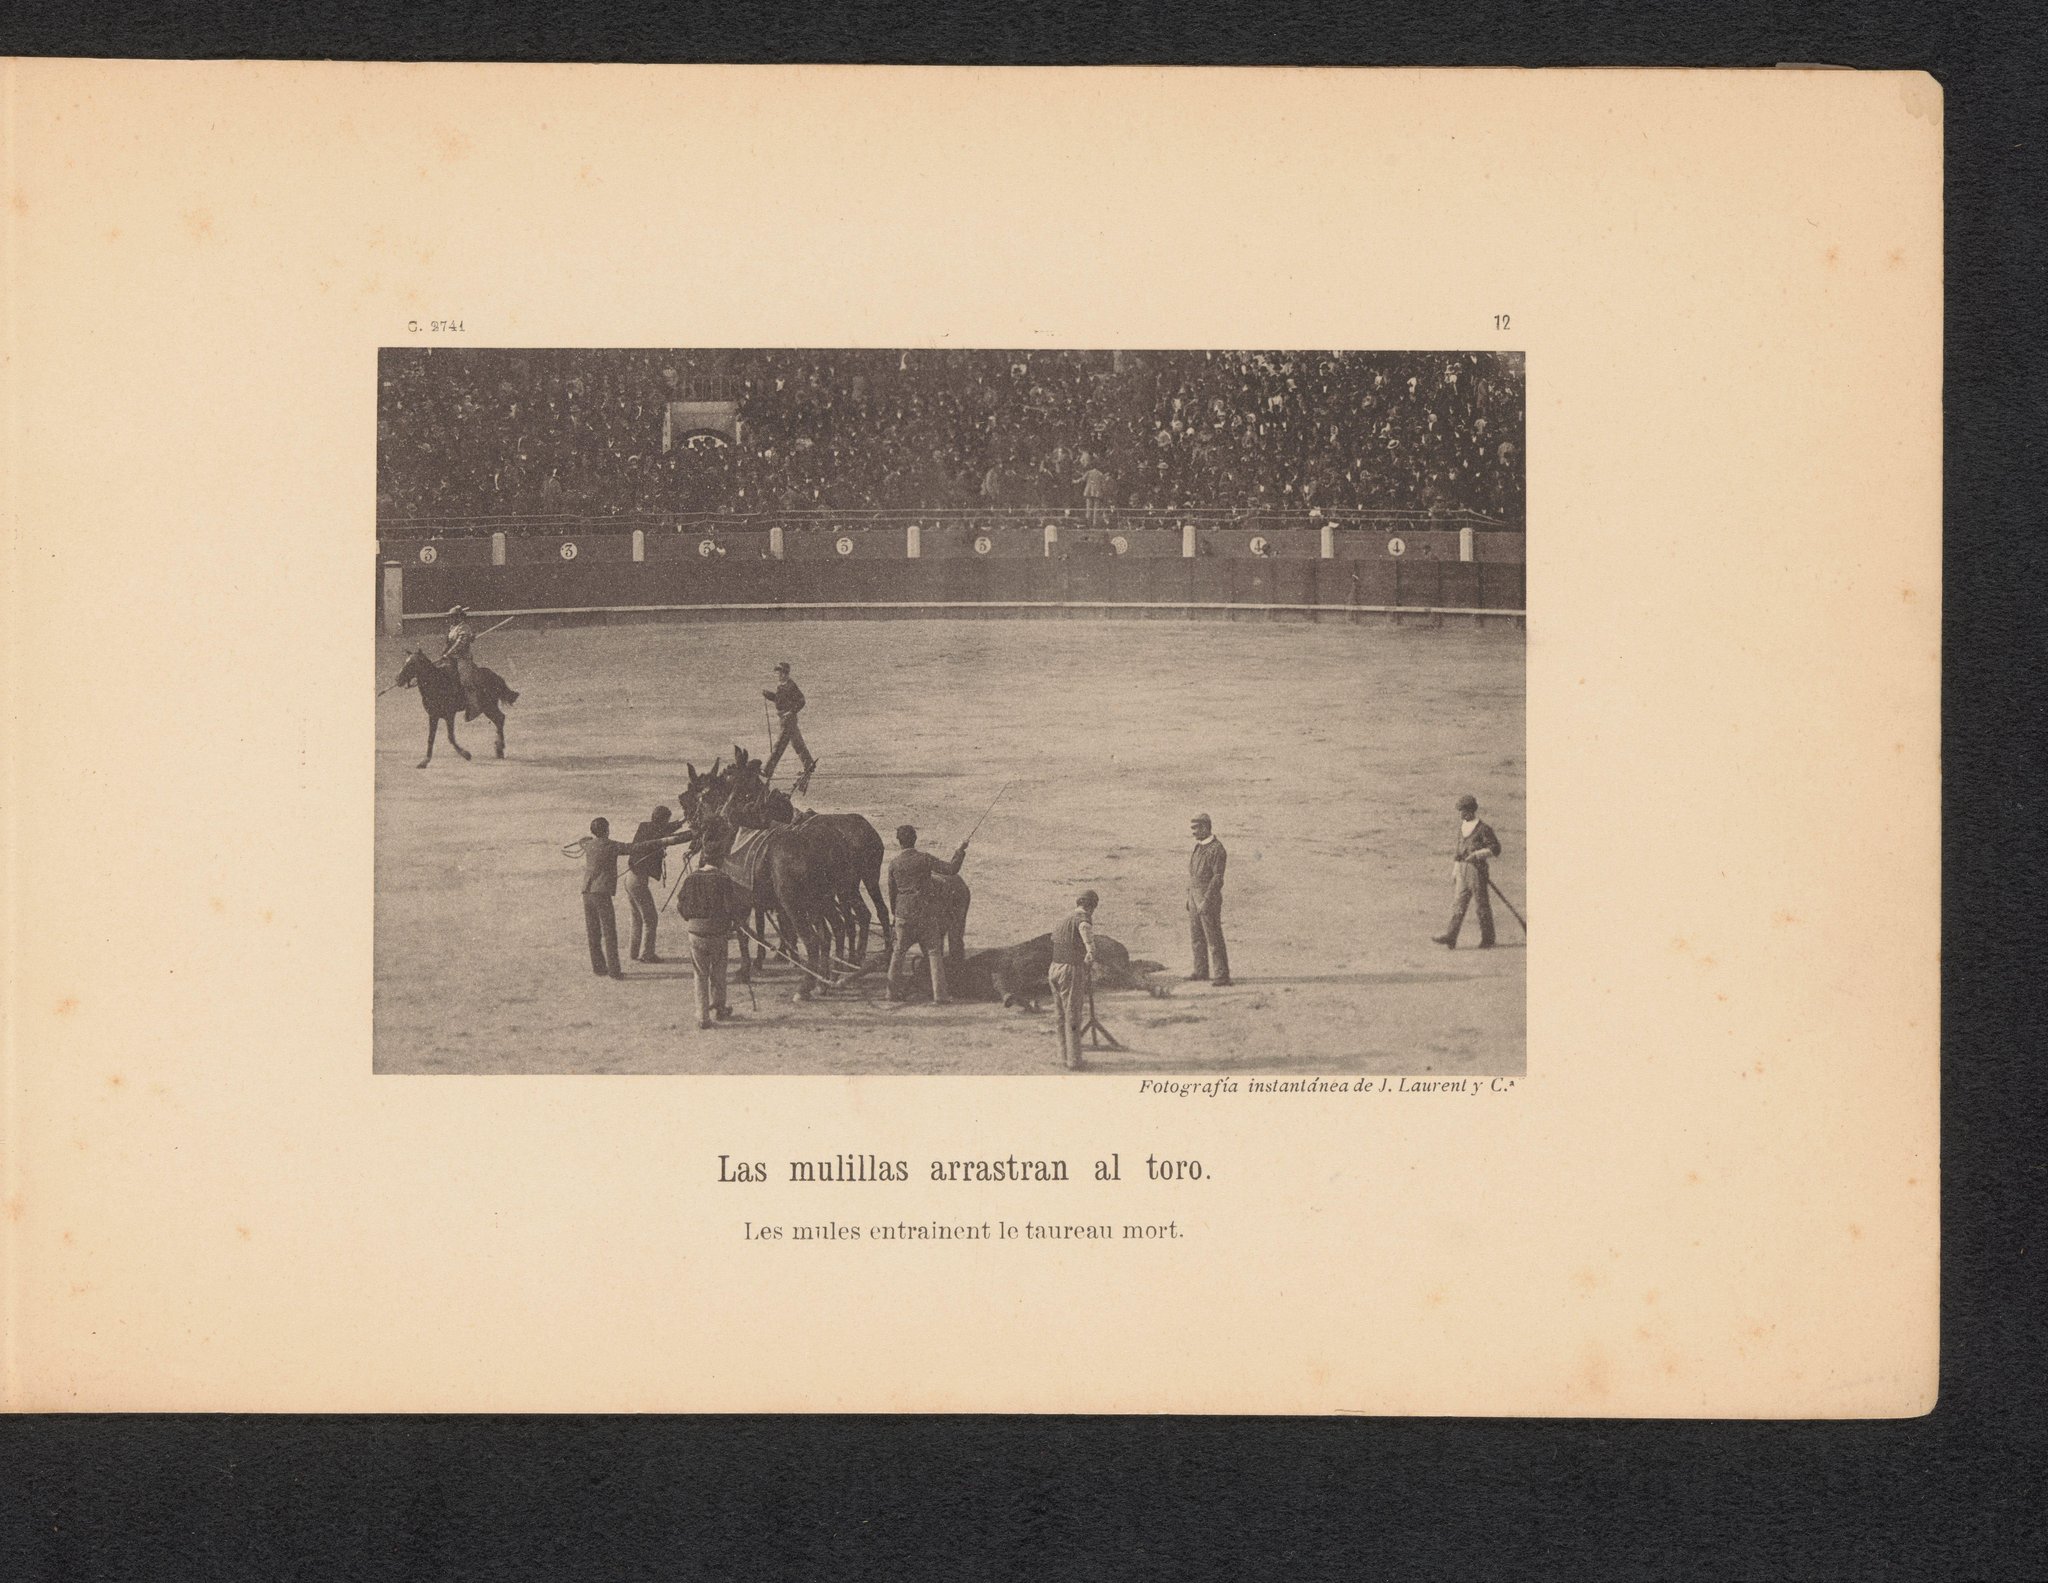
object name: page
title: Muilezels dragen een dode stier uit de stierenvechtersarena van Carretera de Aragon te Madrid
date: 1880-1890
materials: paper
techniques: photograph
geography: madrid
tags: bull, bullfight, bull-fighter, toreador, mule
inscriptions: number: ‘C. 2741’, number: ‘12’